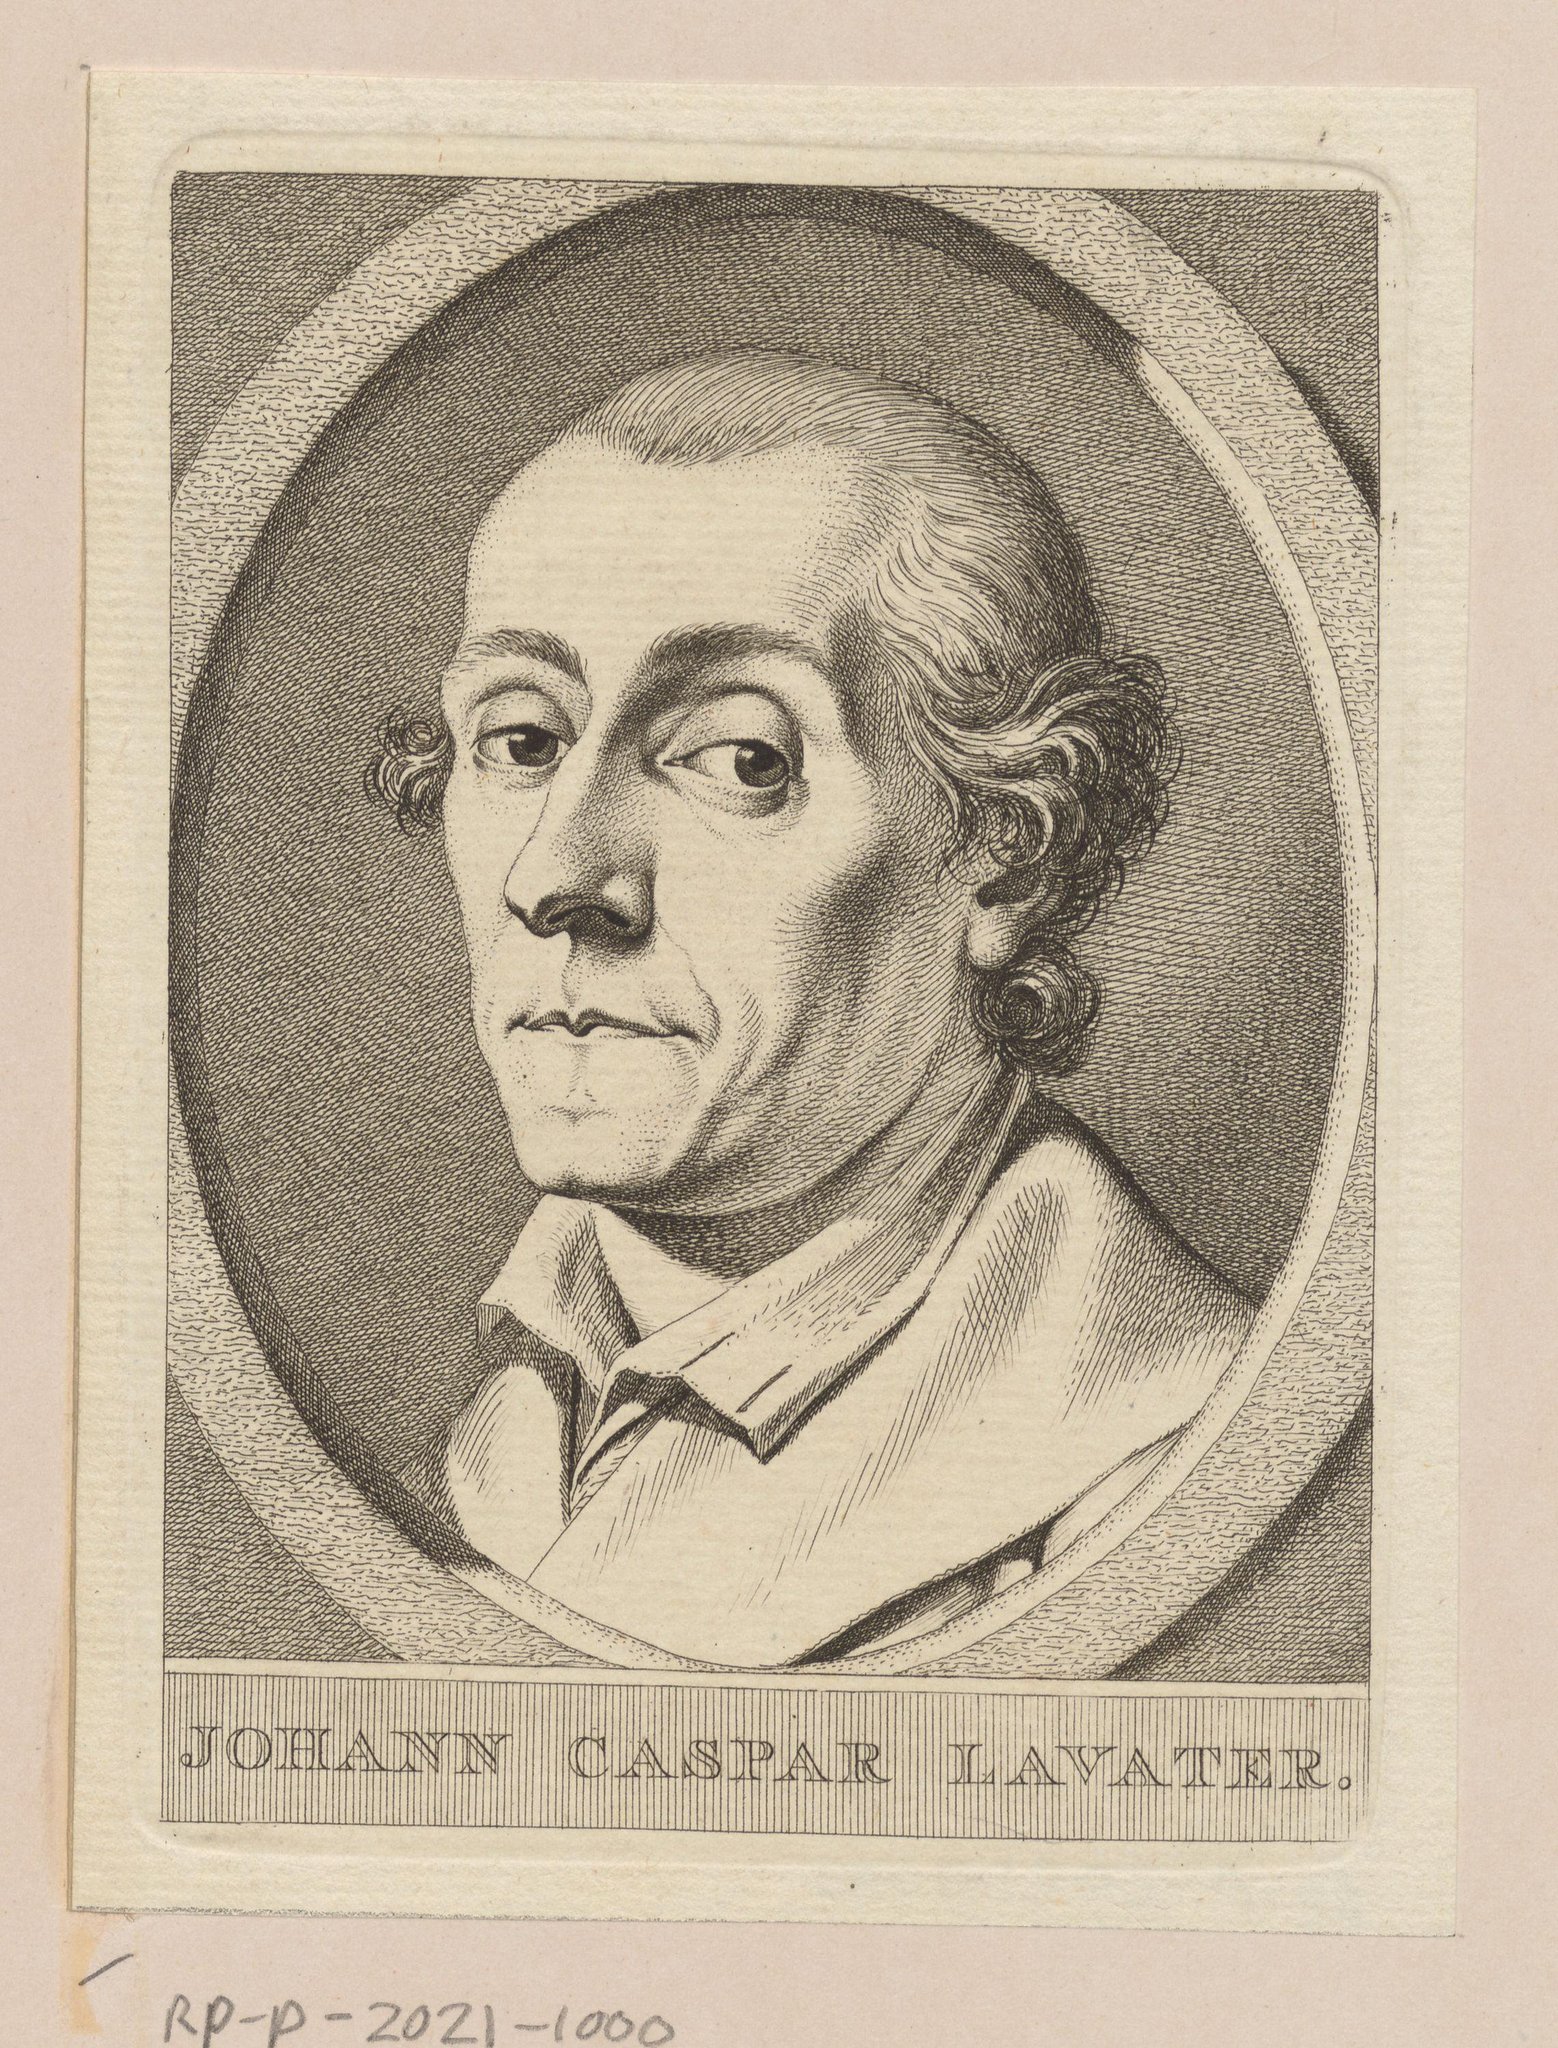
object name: print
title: Portret van Johann Caspar Lavater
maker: Anonymous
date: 1780-1830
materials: paper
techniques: etching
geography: germany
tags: johann caspar lavater, ornament ~ medallion, historical persons, scholar, philosopher (+ portrait of scholar, scientist)